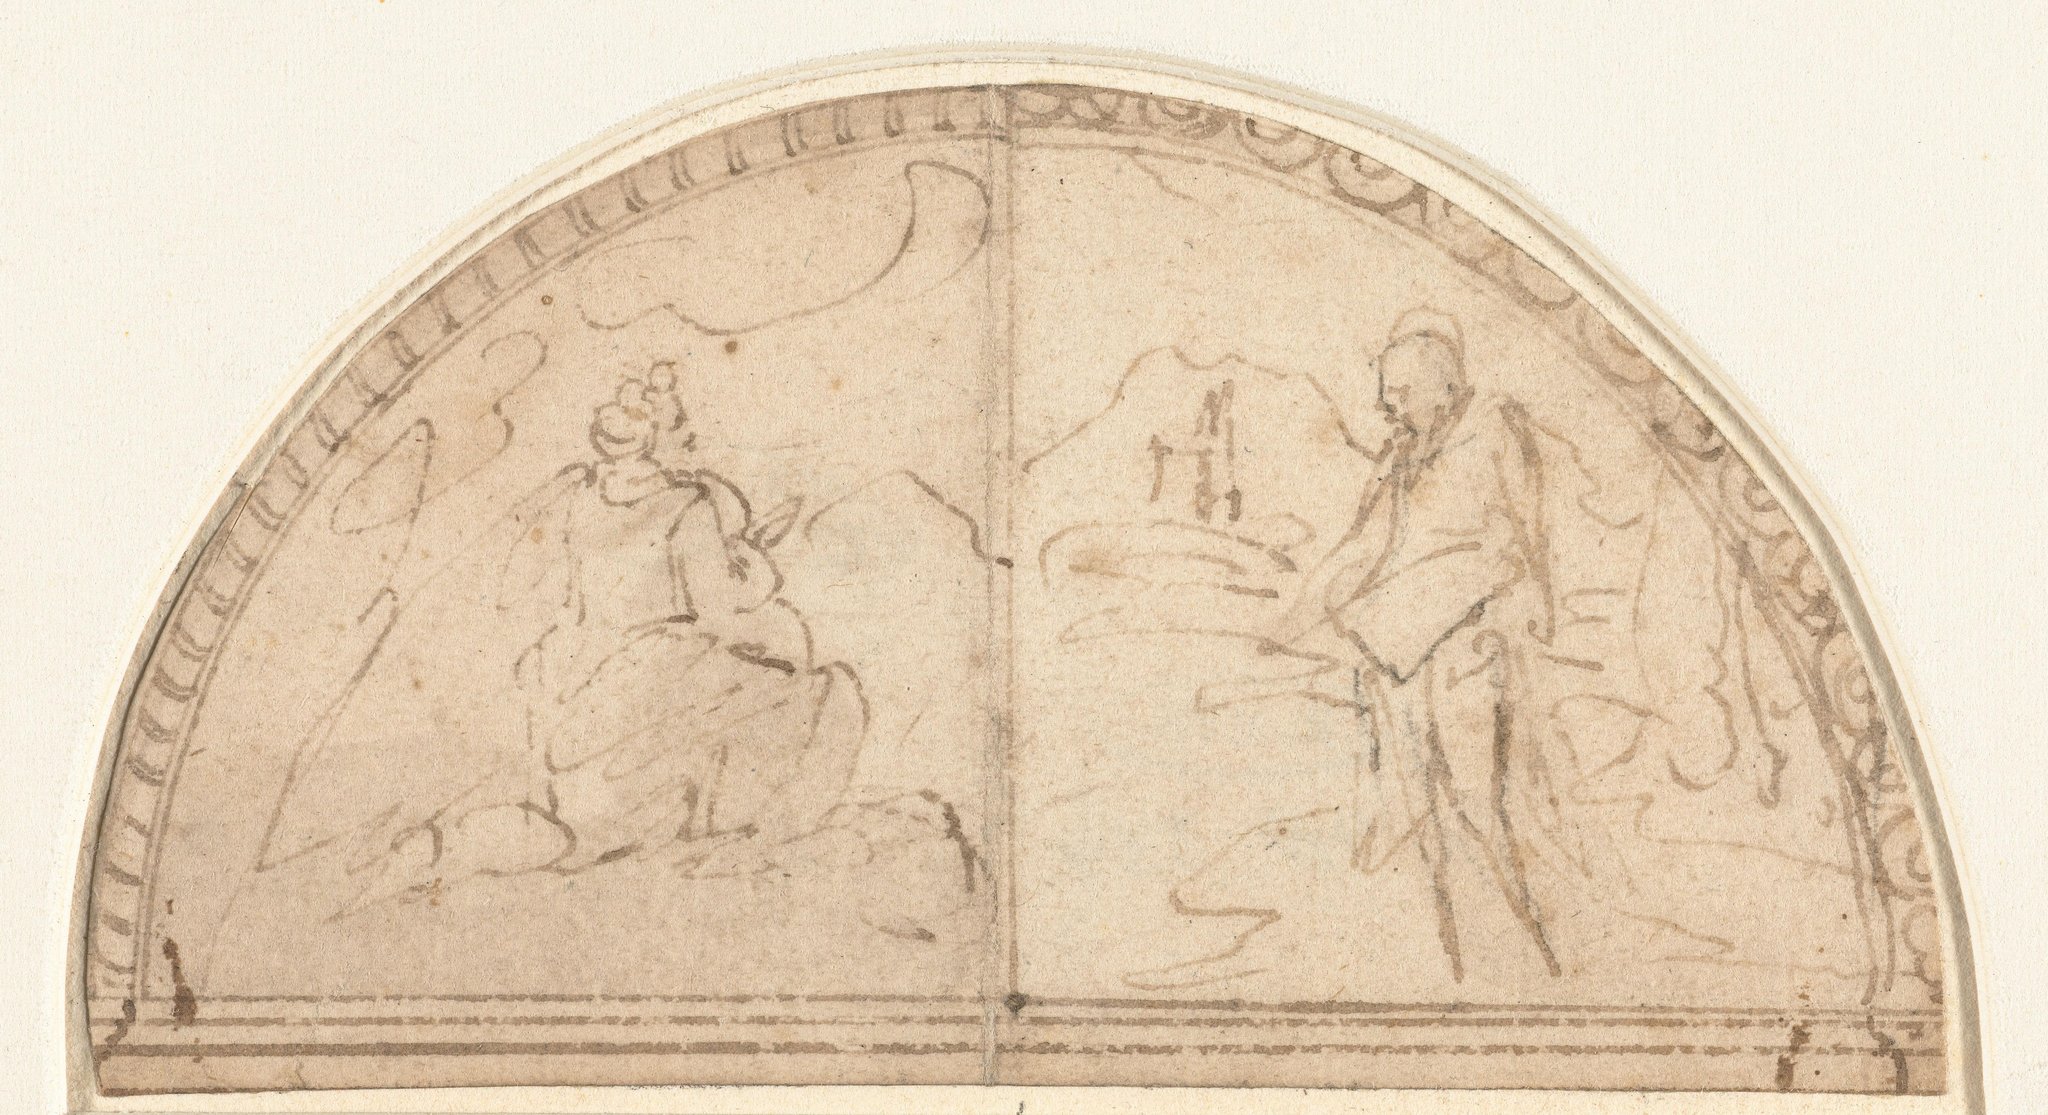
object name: design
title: De verzoeking van Christus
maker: perino del vaga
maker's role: draughtsman, painter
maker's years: 1501-1547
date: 1520-1547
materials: ink, paper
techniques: pen